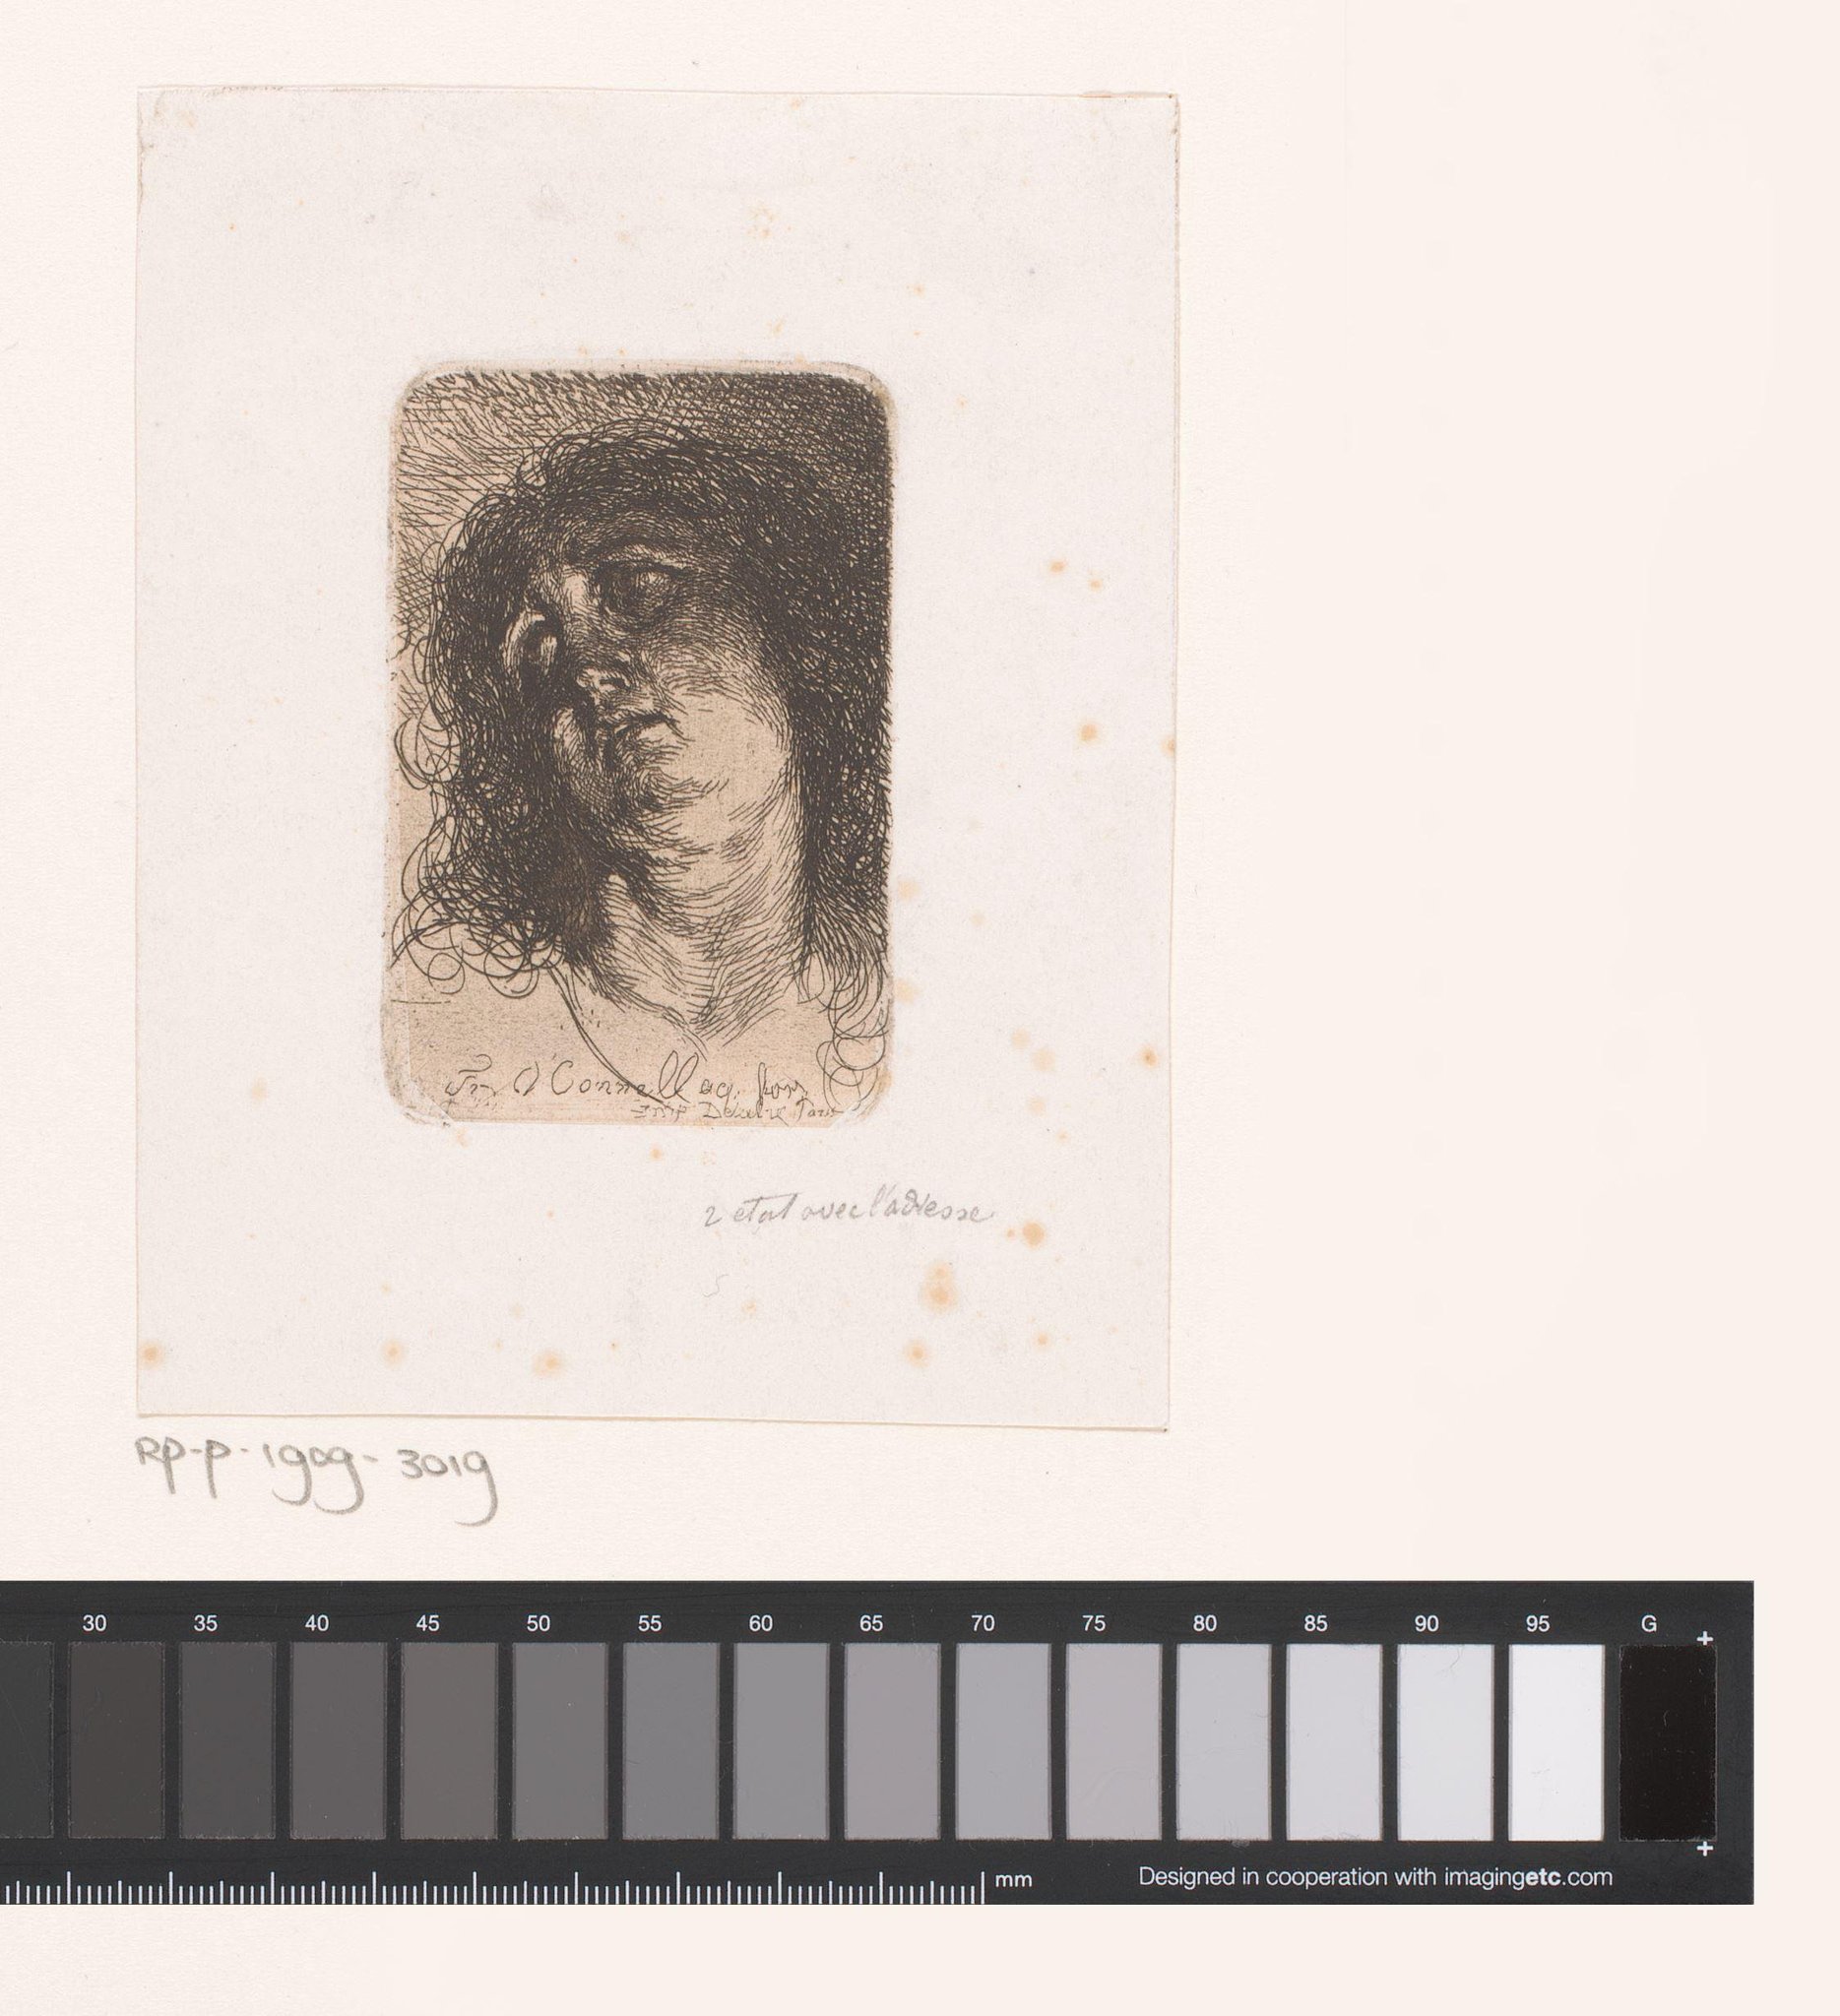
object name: print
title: Portret van Maria Magdalena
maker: frédérique émile auguste oconnell-miethe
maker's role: print maker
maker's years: 1823-1885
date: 1833-1885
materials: paper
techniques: etching, intaglio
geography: paris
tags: the penitent harlot mary magdalene; possible attributes: book (or scroll), crown, crown of thorns, crucifix, jar of ointment, mirror, musical instrument, palm-branch, rosary, scourge - portrait of female saint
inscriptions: collector's mark: Lugt 2228